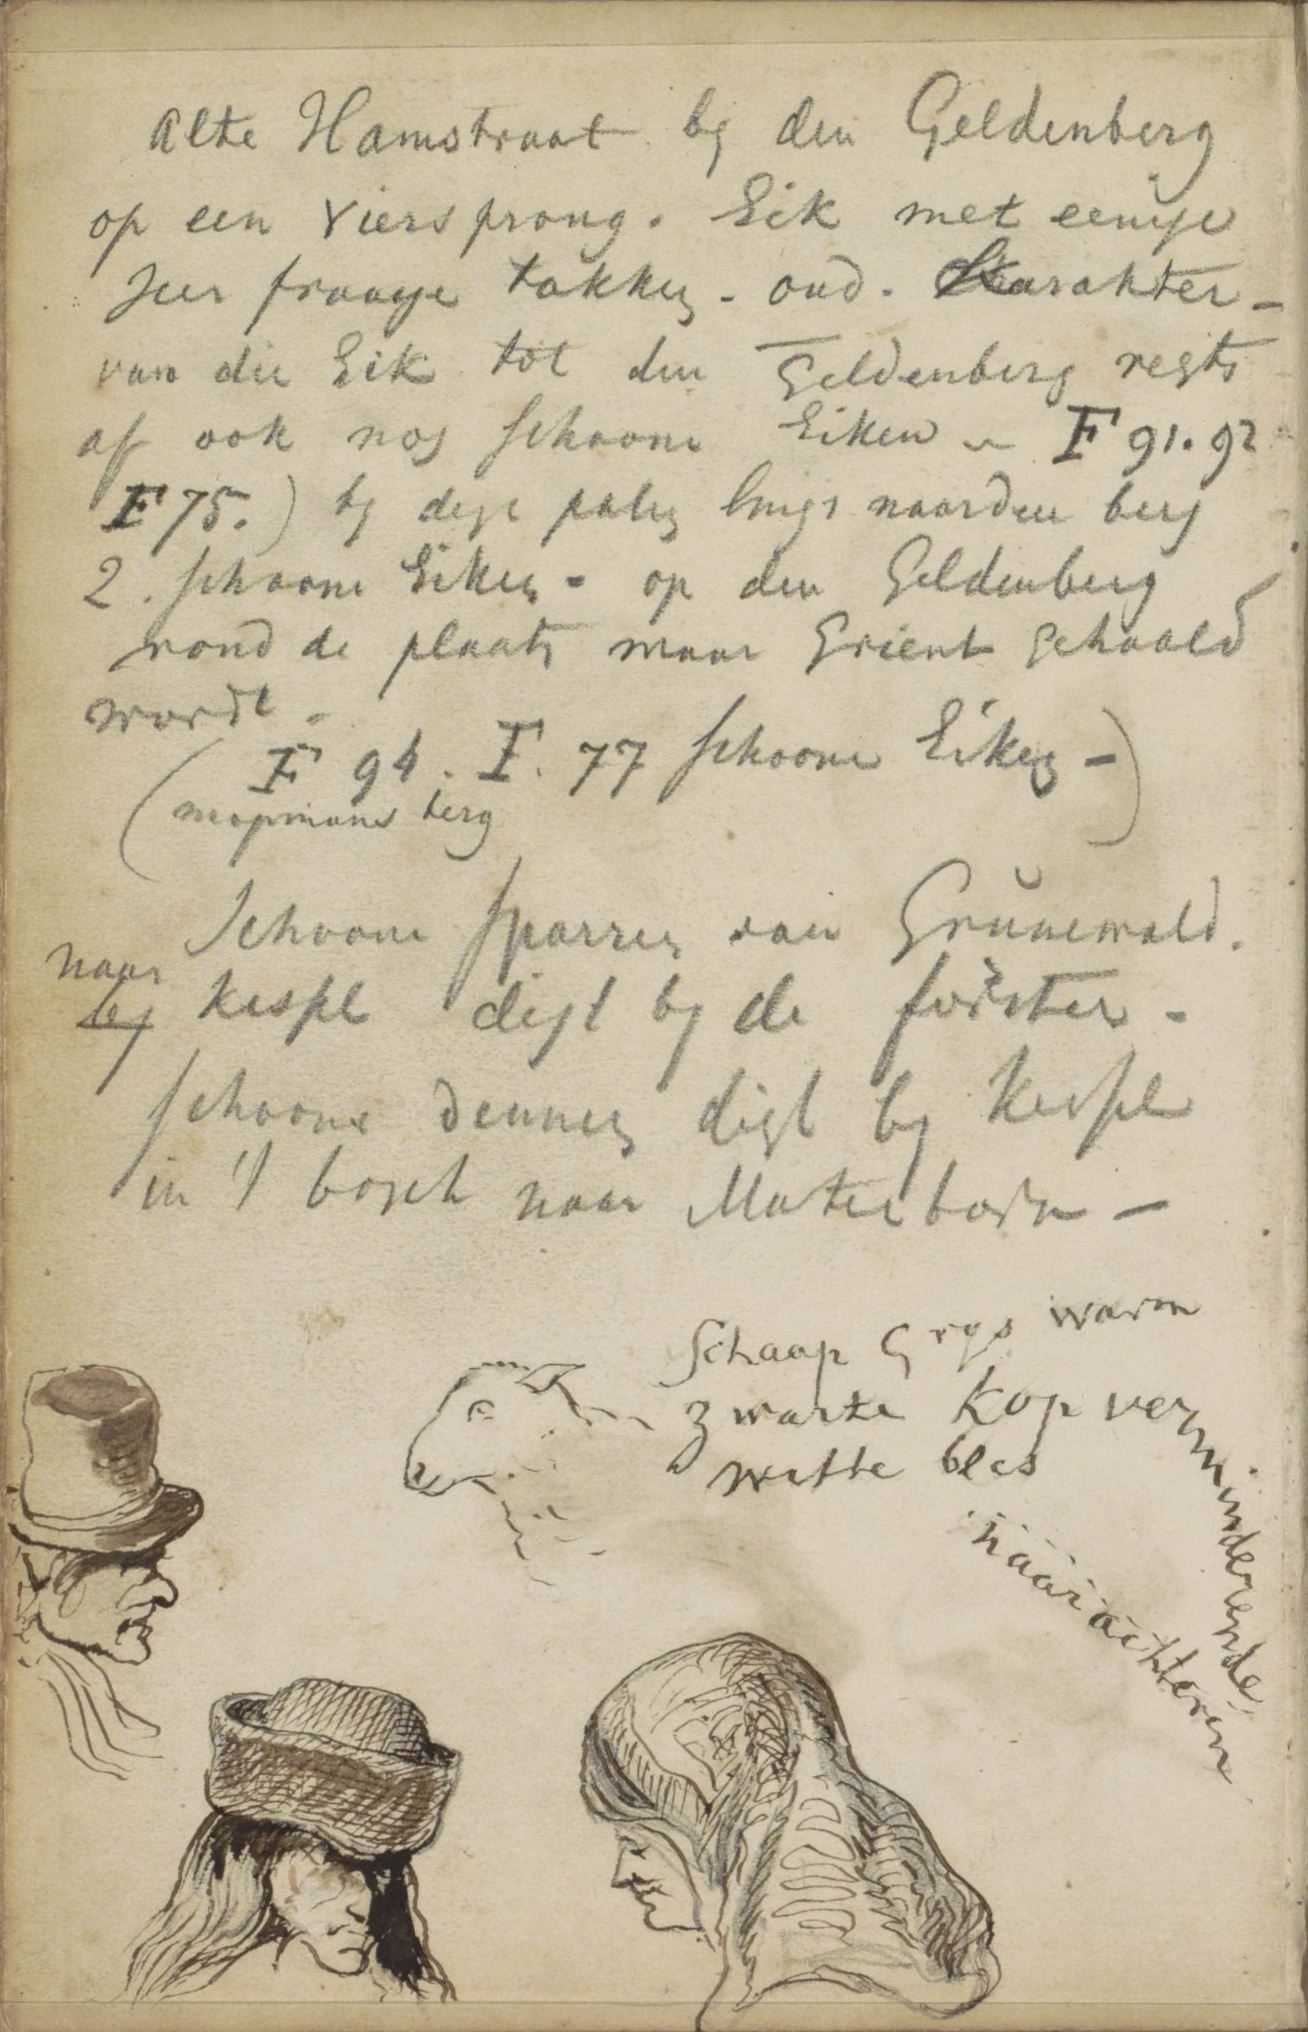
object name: sketchbook leaf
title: Mannenkoppen met verschillende hoofddeksels en een schaap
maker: johannes tavenraat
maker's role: draughtsman, painter, print maker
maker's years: 1809-1881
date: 1839-1872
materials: ink, paper, pencil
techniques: pen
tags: head (human), adult man, head-gear: hat (+ men's clothes), sheep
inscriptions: annotation: ‘[...]’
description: Blad 73 verso uit een schetsboek met 73 bladen.